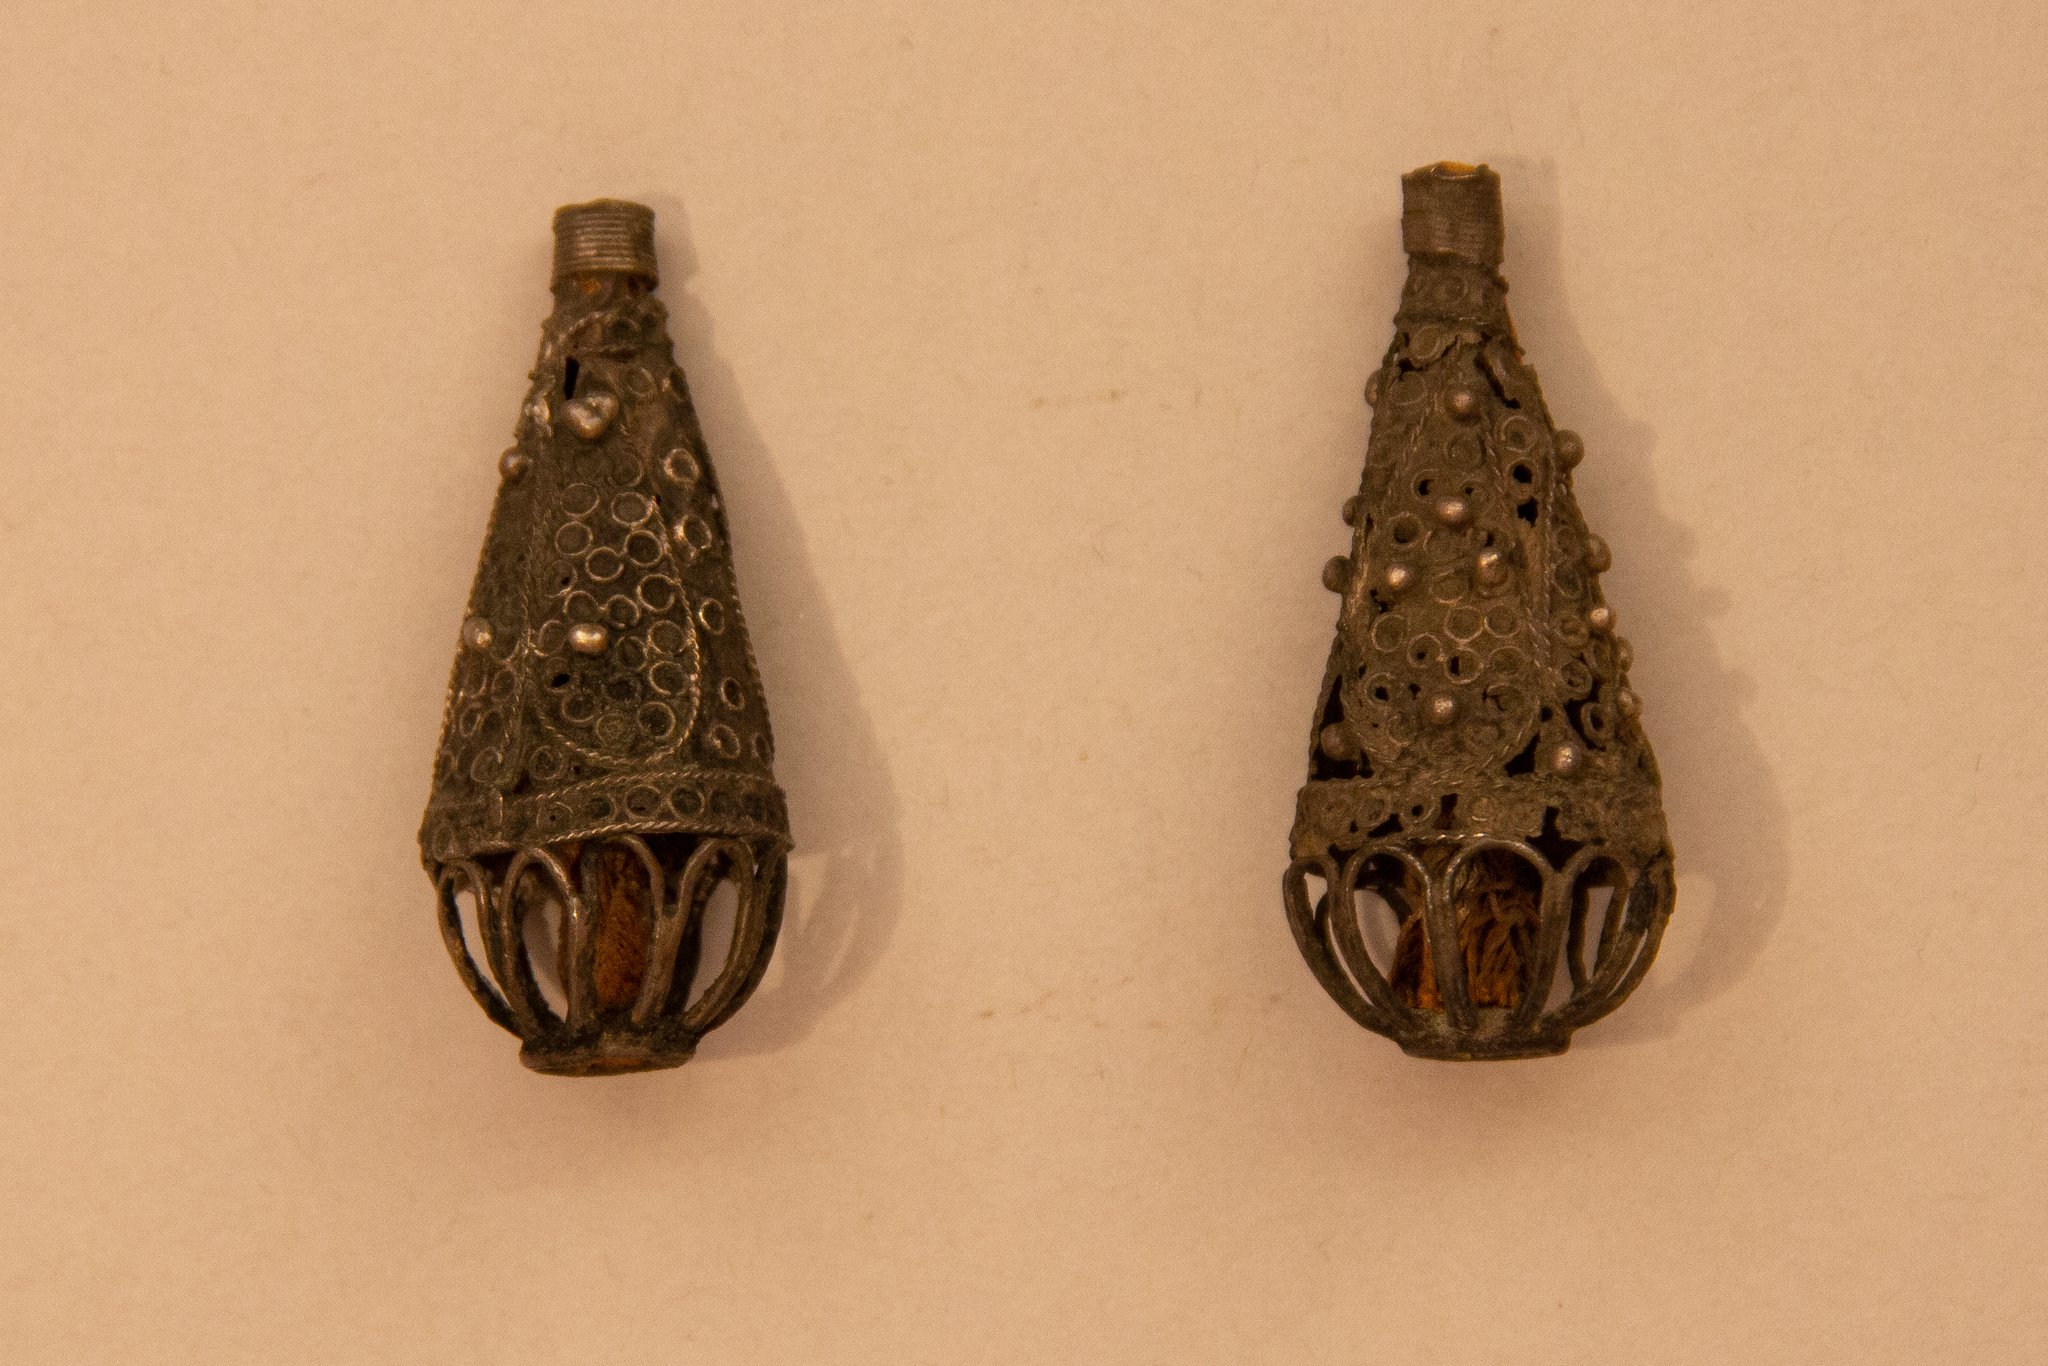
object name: pendant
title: Pendants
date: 1301-1500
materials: silver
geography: morocco